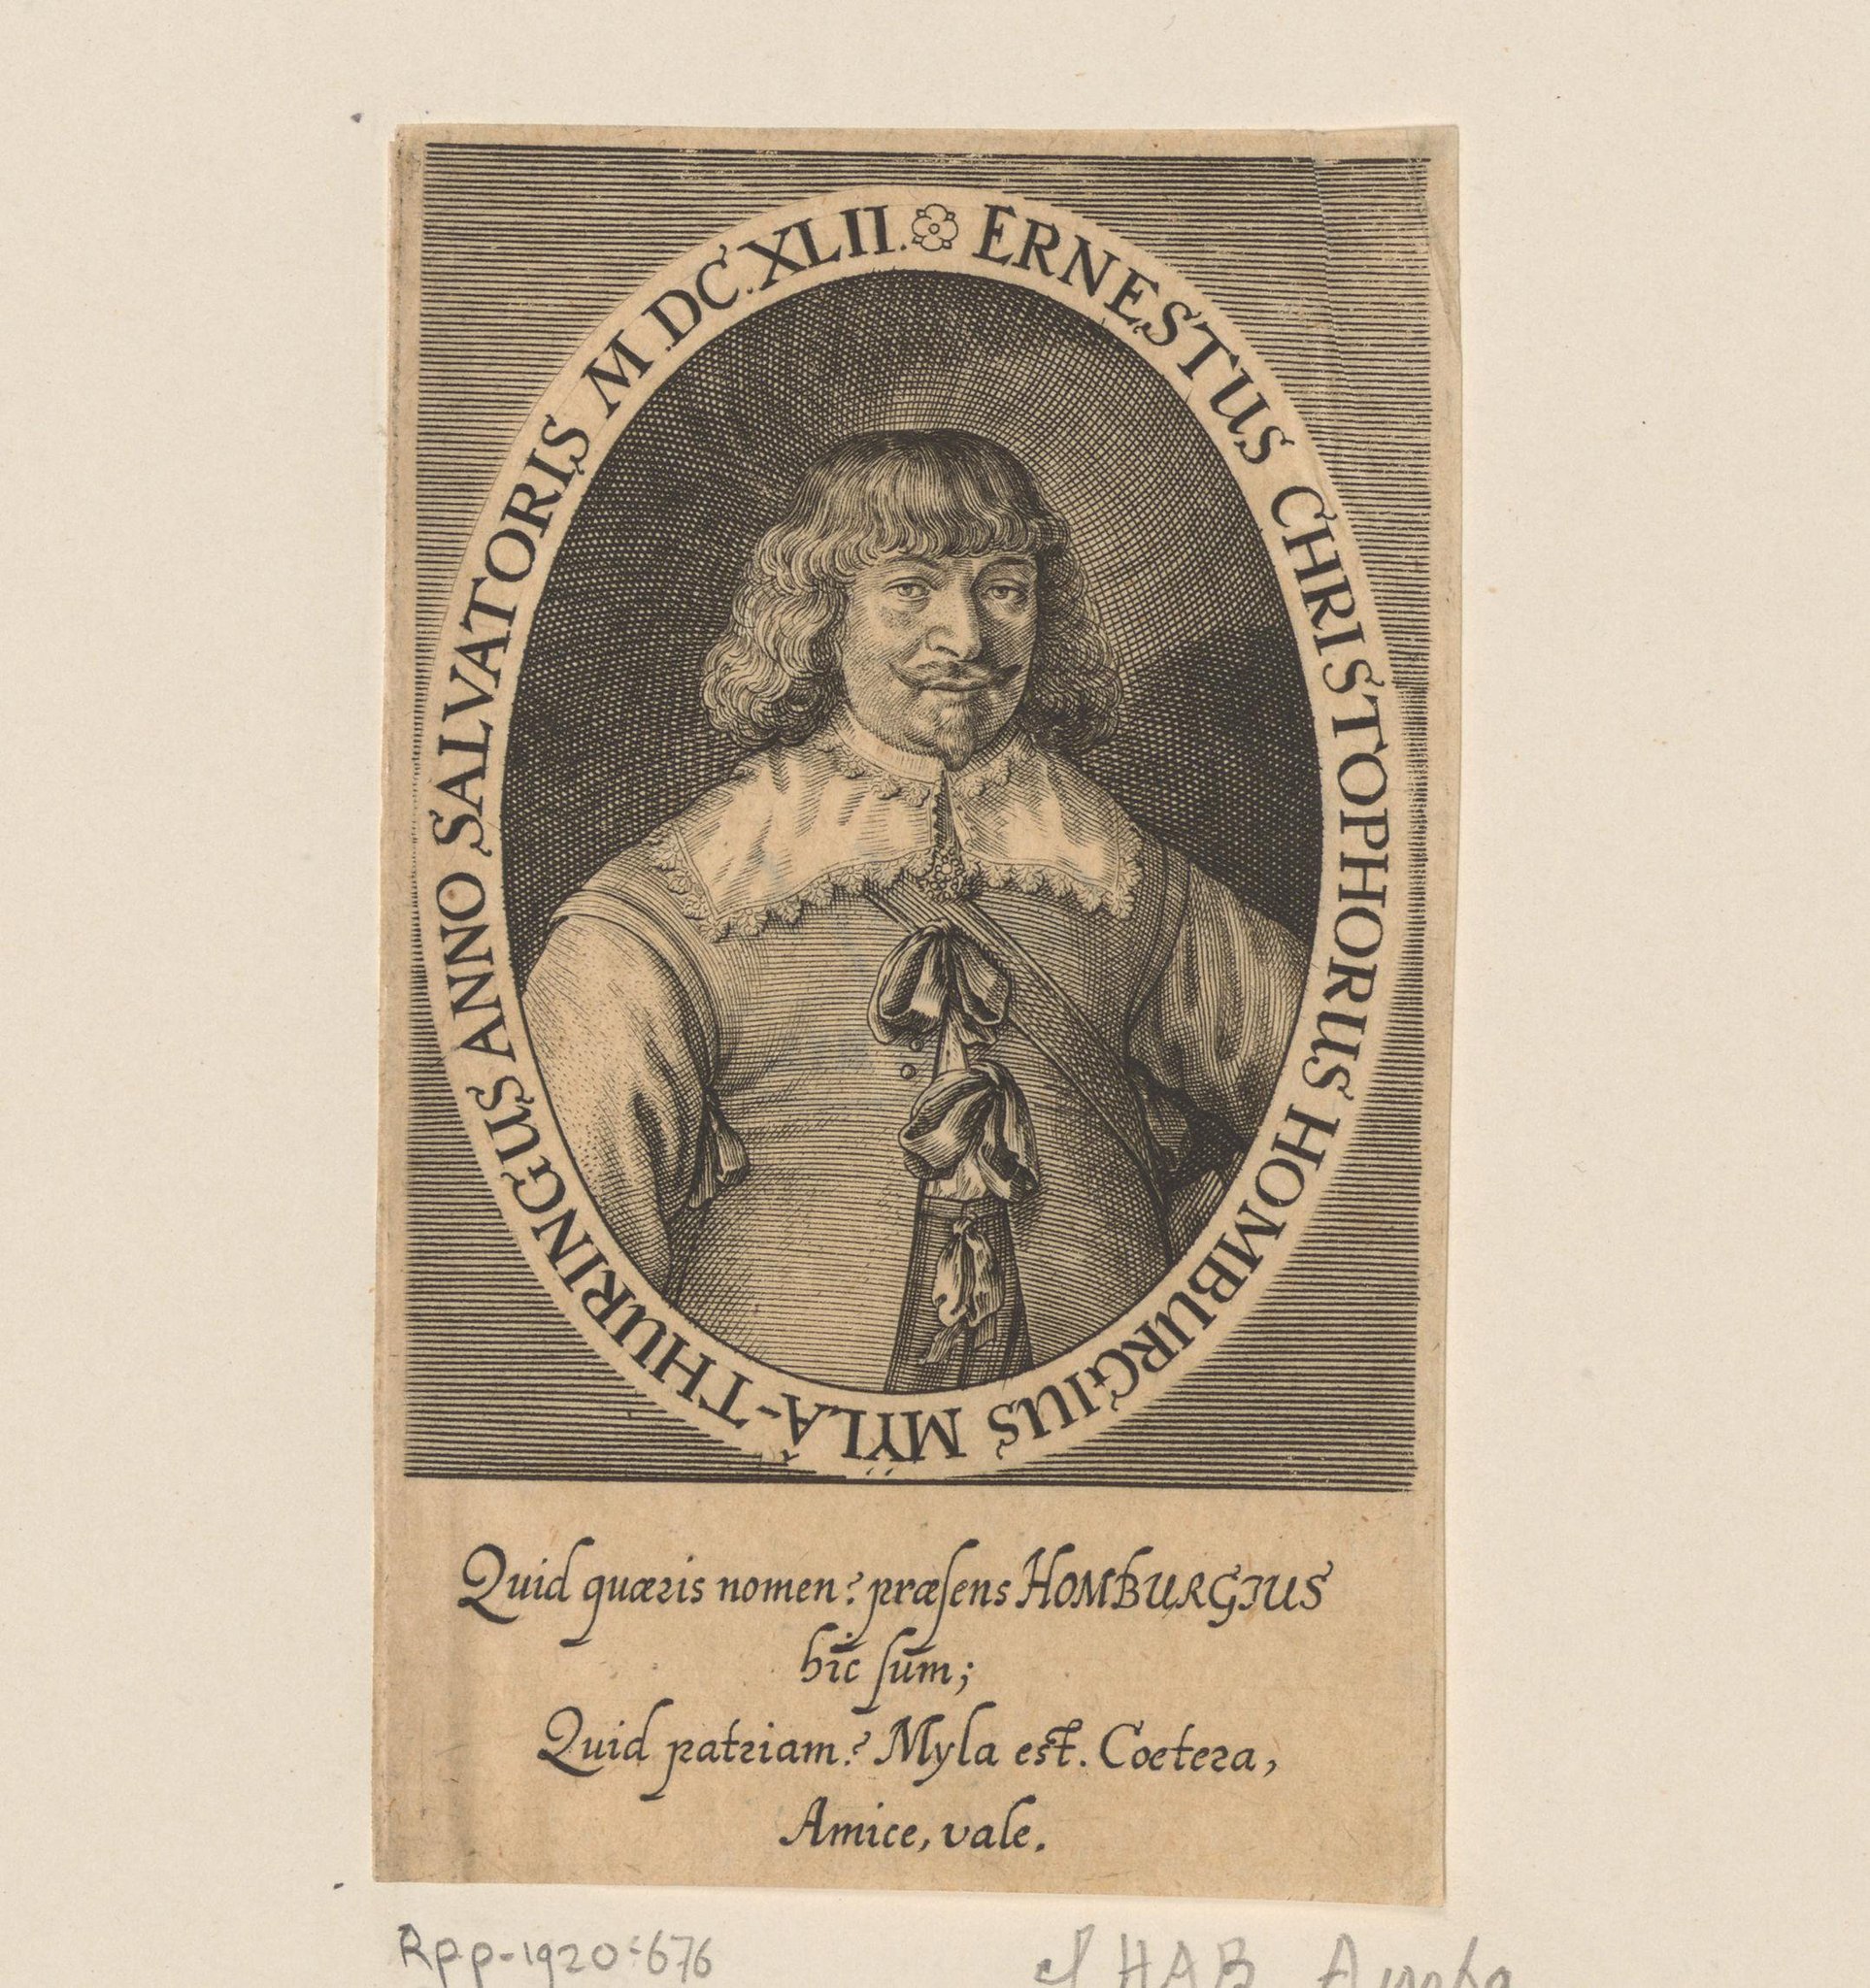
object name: print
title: Portret van Ernst Christoph Homburg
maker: Anonymous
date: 1642-1724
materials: paper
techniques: engraving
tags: historical persons, portrait of a writer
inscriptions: collector's mark: Lugt 2228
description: Onder het portret vier regels in het Latijn.